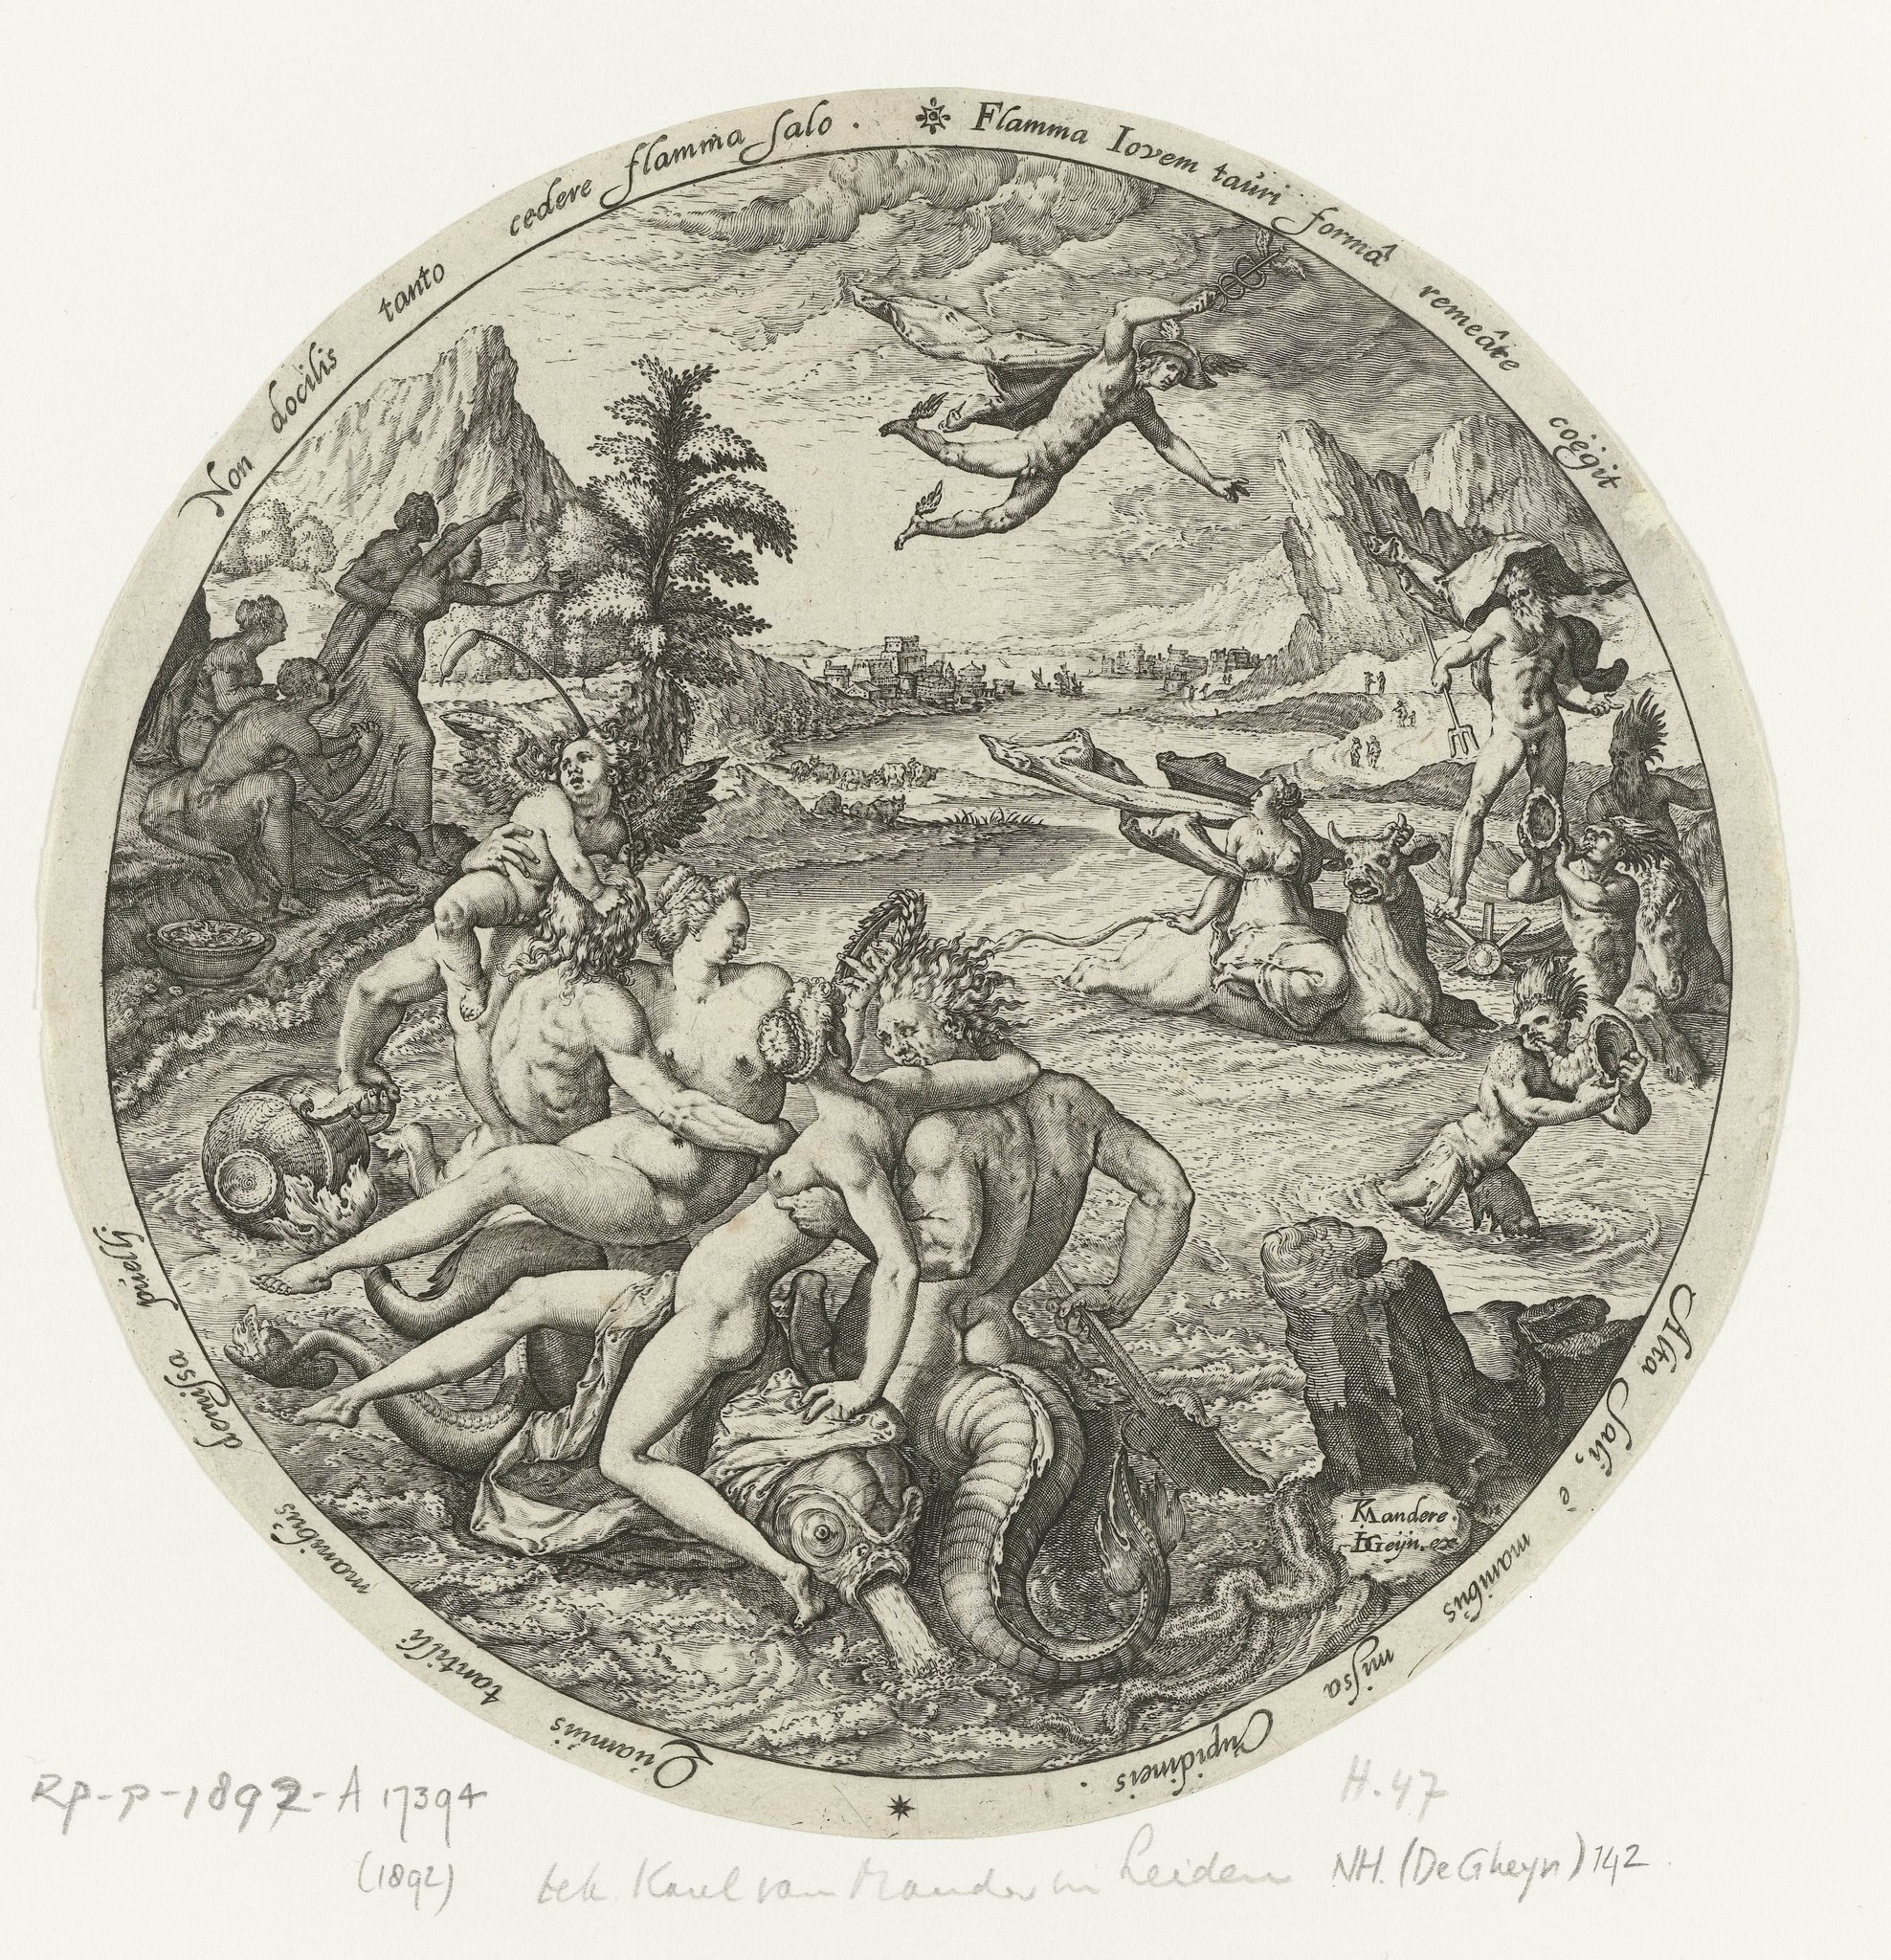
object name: print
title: De roof van Europa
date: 1592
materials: paper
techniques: engraving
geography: leiden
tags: jupiter, usually in the shape of a white bull, abducts europa and carries her across the water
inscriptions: collector's mark: Lugt 2228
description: Jupiter ontvoert in de gedaante van een stier Europa. Haar dienstmaagden proberen het dier nog tegen te houden maar ze worden gehinderd door Nereïden. Mercurius die in de lucht vliegt ziet het drama gebeuren. Rechts in de golven staat Neptunus met zijn drietand.